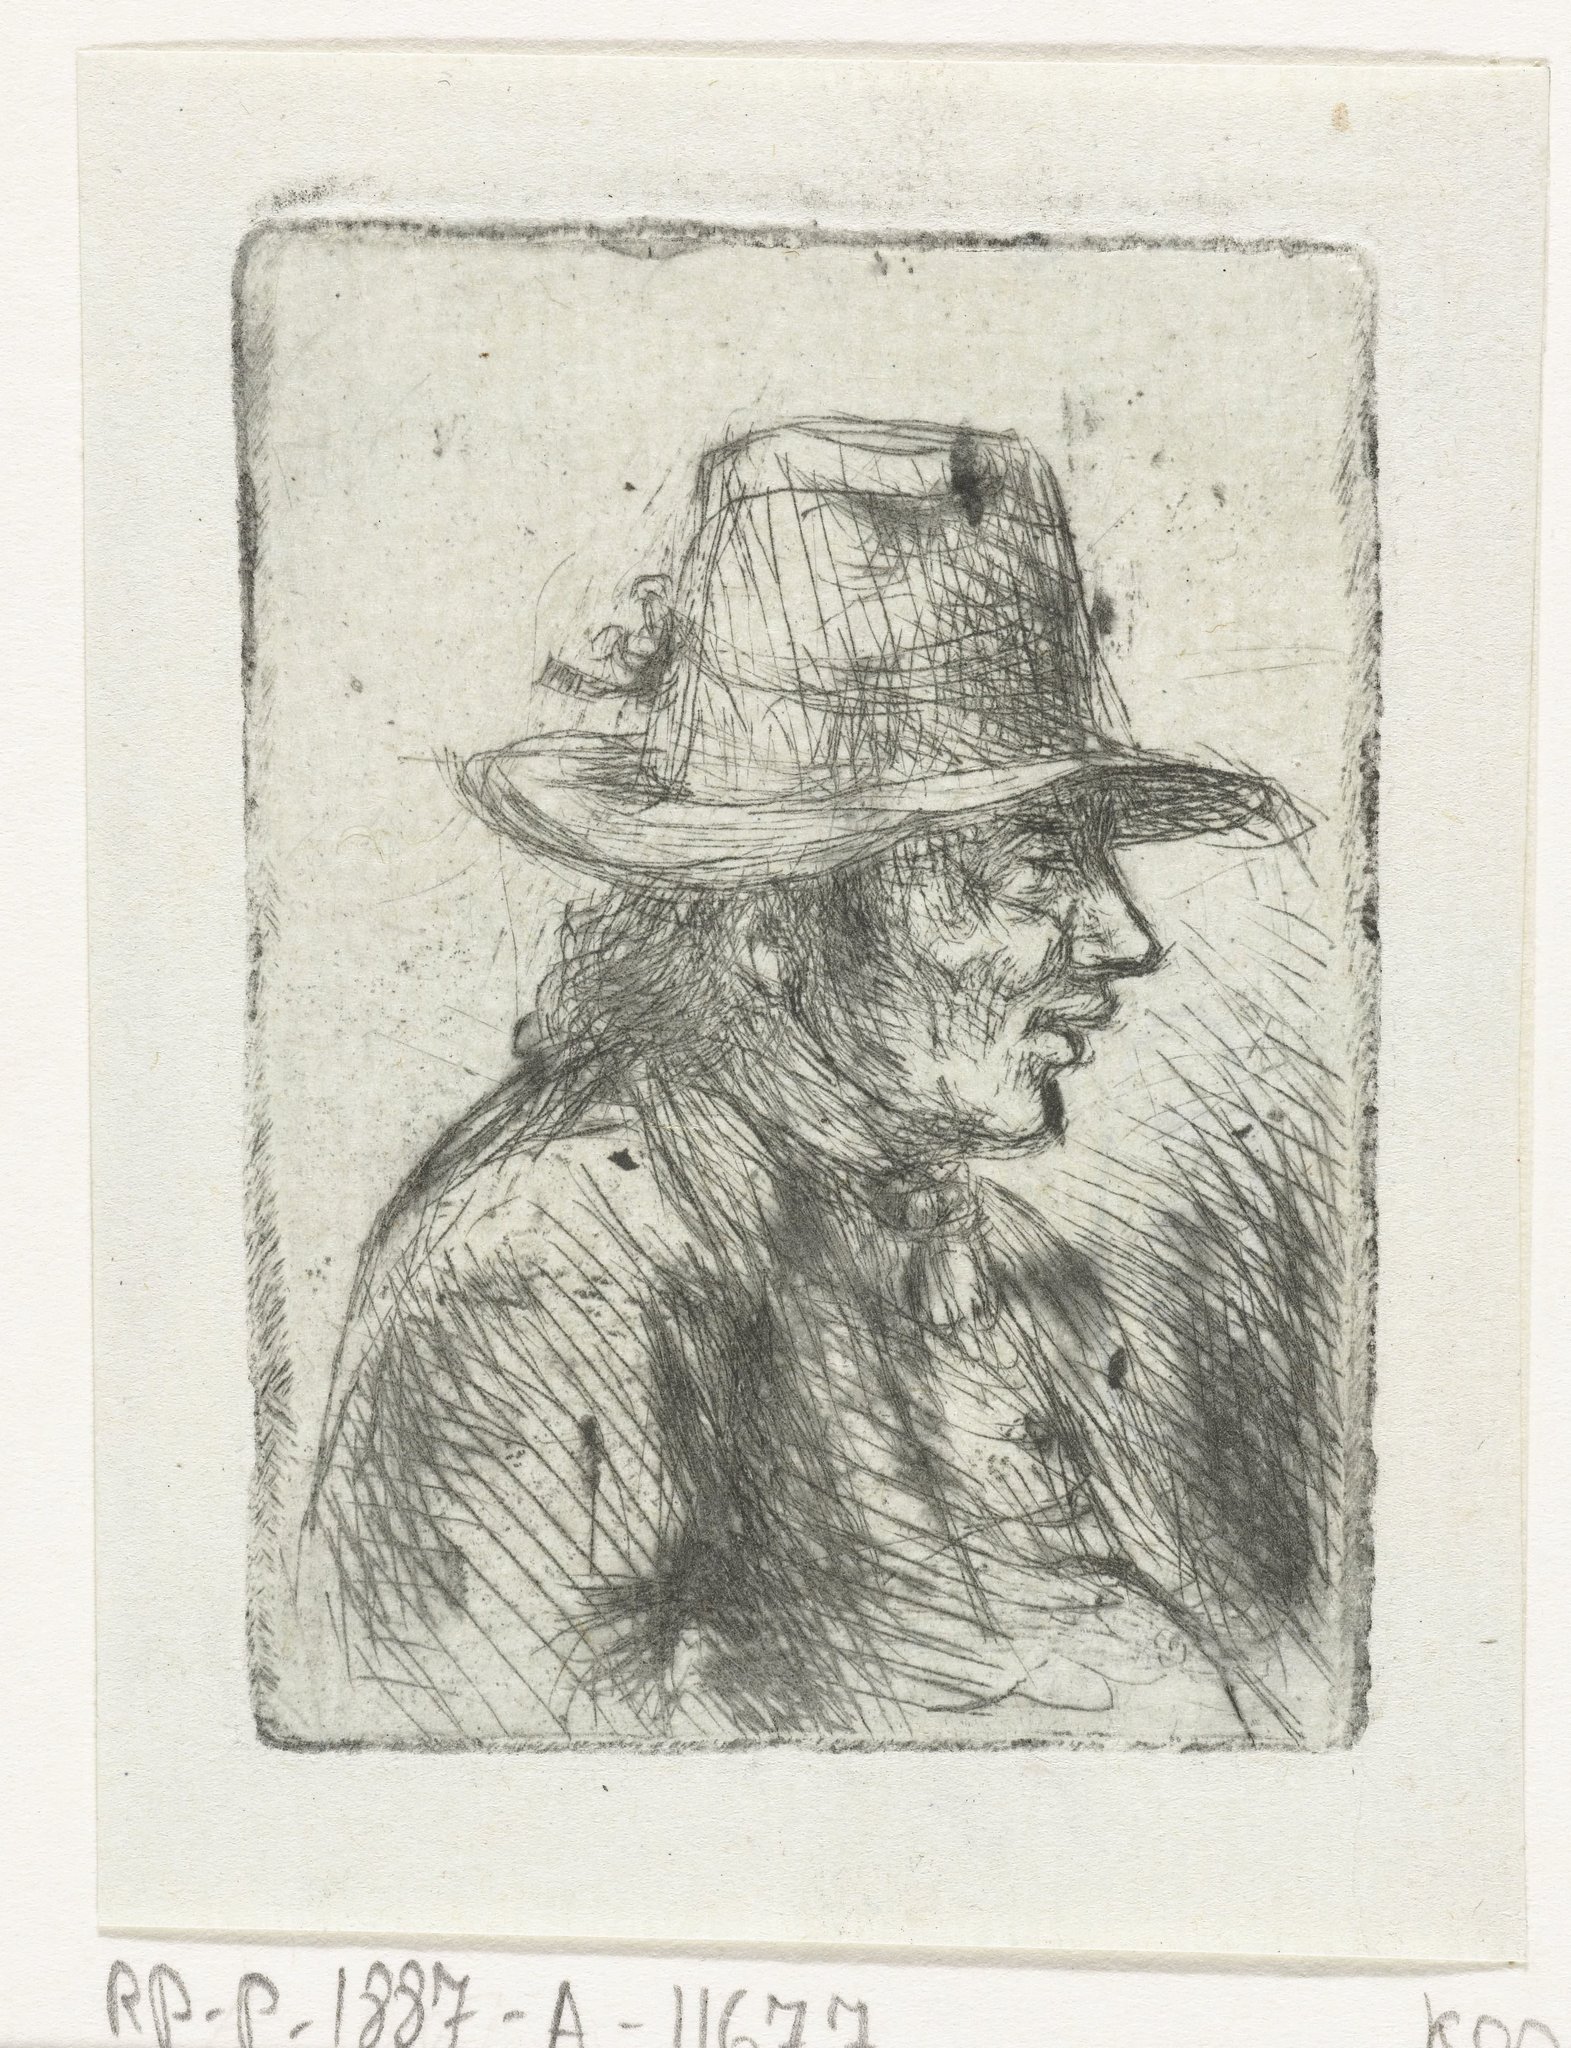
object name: print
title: Man met hoed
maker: jan chalon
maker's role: print maker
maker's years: 1738-1795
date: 1748-1795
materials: paper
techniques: drypoint, etching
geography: northern netherlands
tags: morphology of human expression (+ adult male (human being))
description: Een volwassen man met hoed. Buste naar rechts.